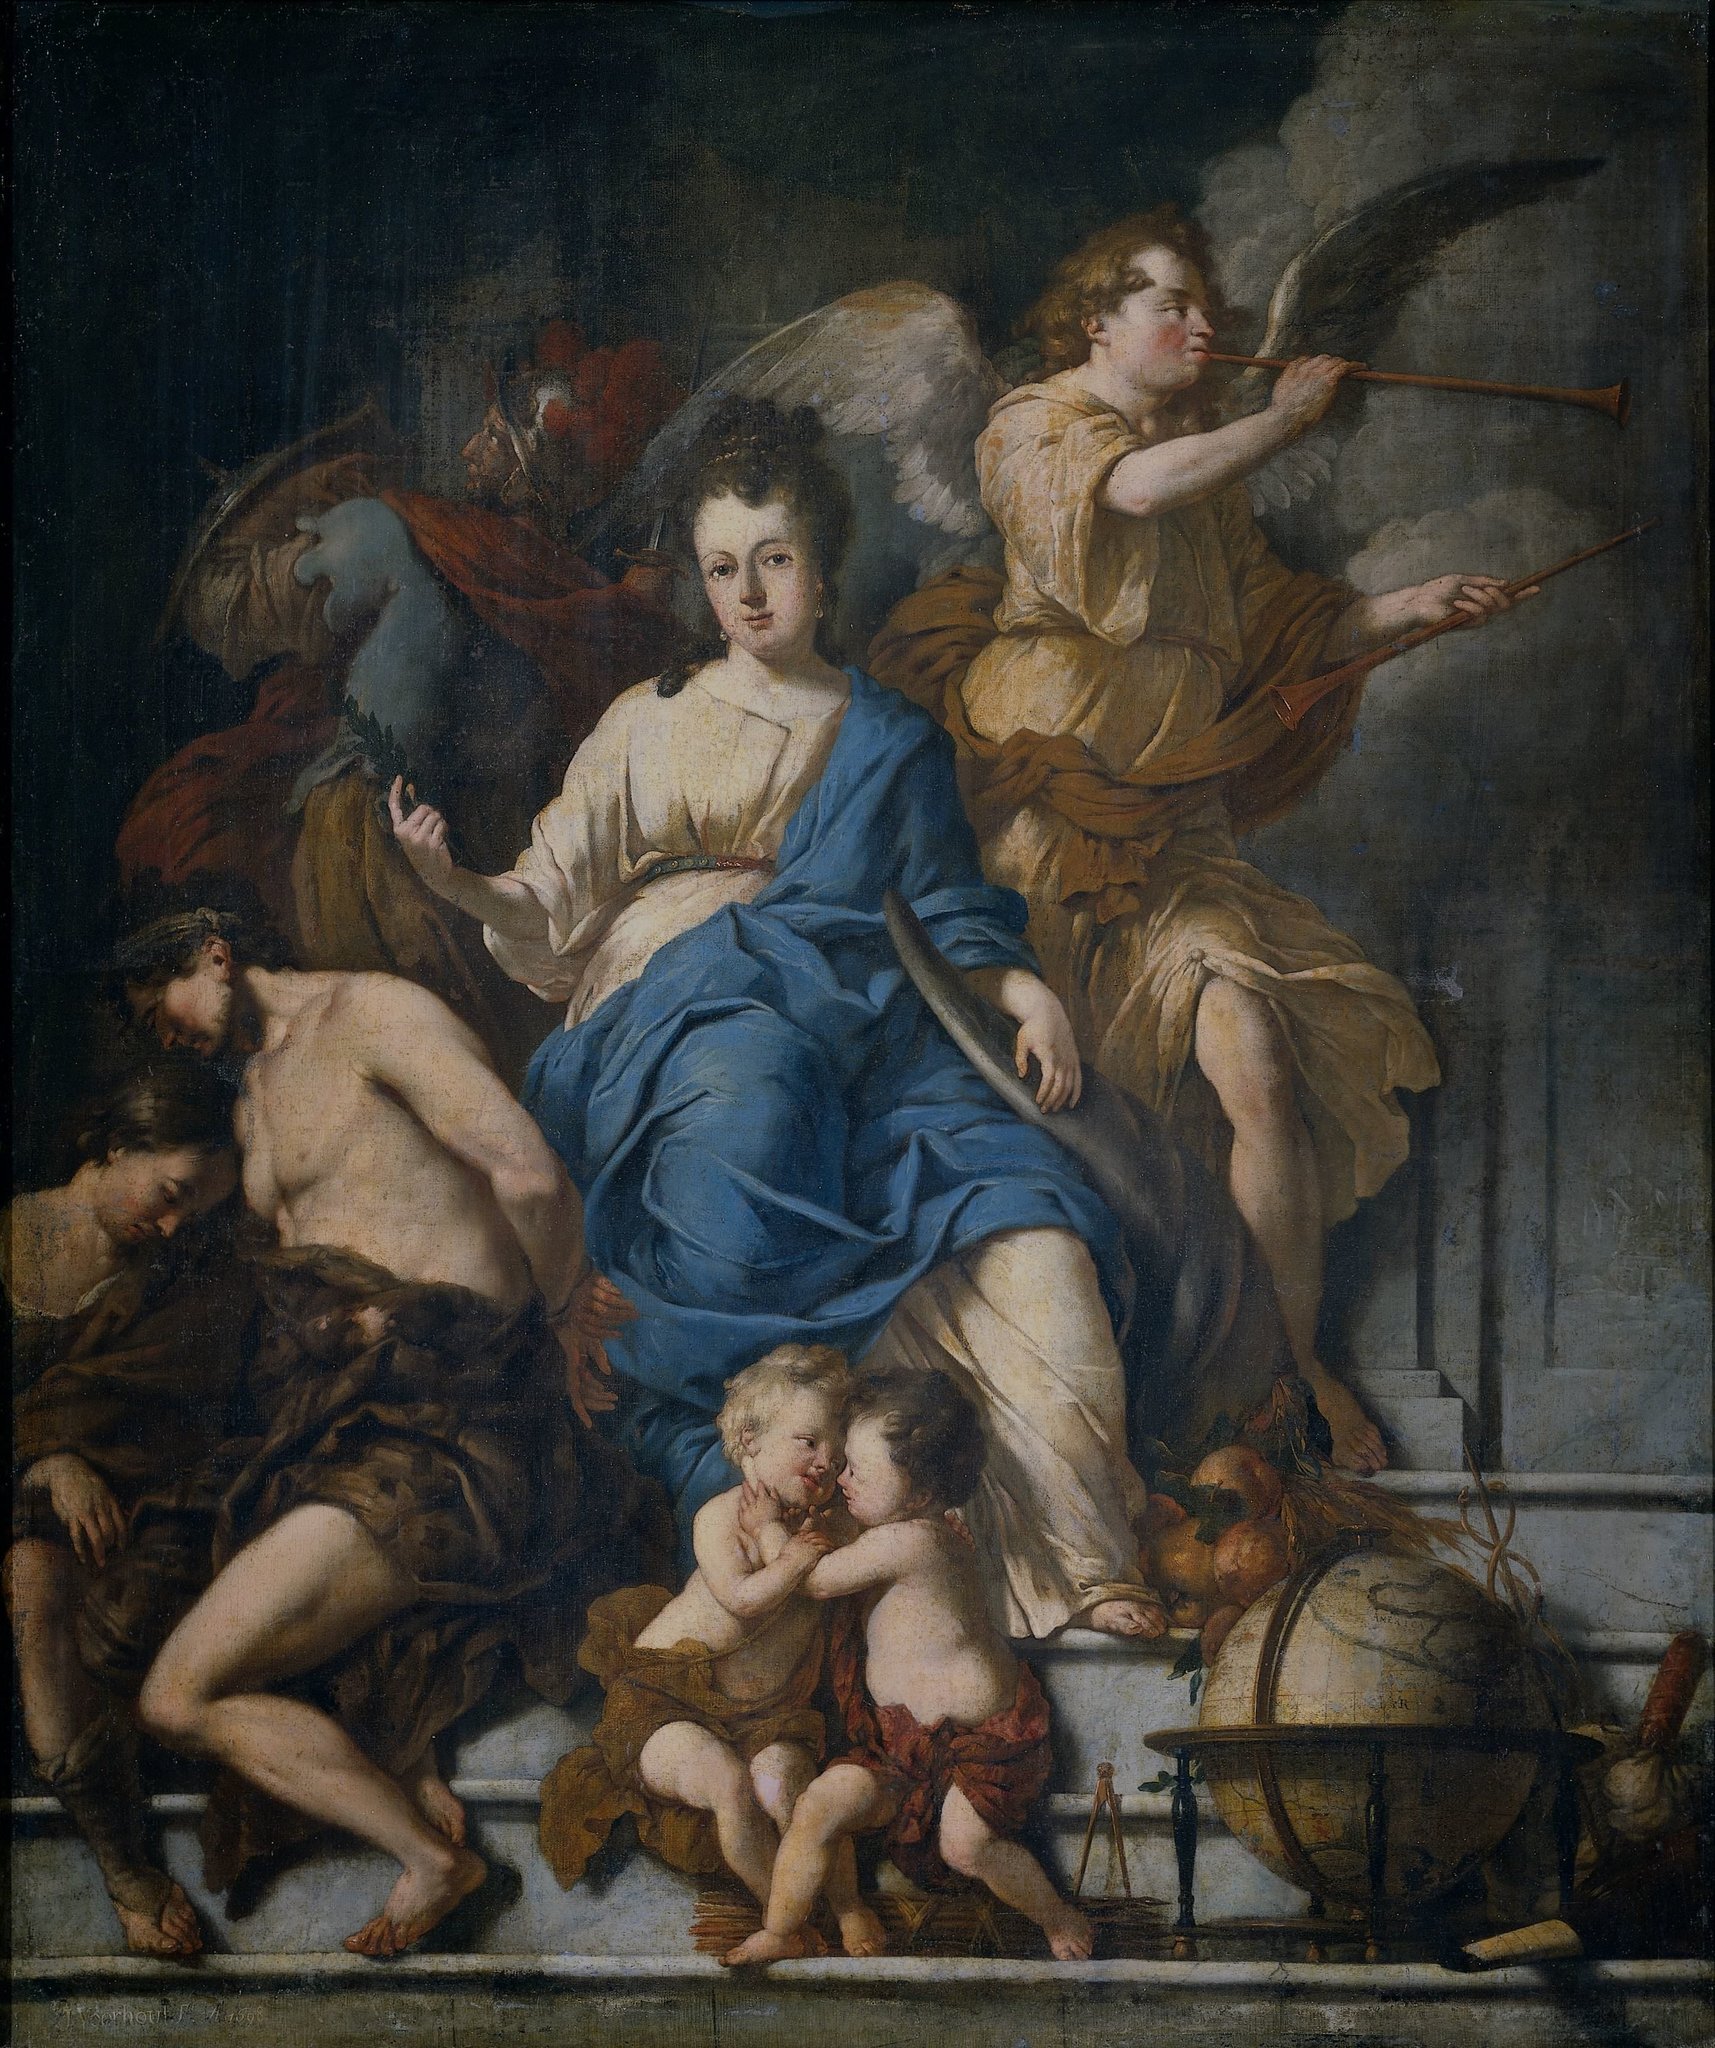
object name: painting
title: Allegory of the Treaty of Ryswick, 1697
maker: johannes voorhout (i)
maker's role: draughtsman, painter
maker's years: 1647-1723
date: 1698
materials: canvas, oil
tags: symbols, allegories of peace, 'pax'; 'pace' (ripa), fame; 'fama', 'fama buona', 'fama chiara' (ripa) (+ personification), prisoner of war (after the battle)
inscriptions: signature and date: ‘J. Voorhout Ft A 1698’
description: De zittende vrouw symboliseert de vrede. Zij toont een olijftak en een hoorn des overvloeds, want 'vrede baart overvloed'. Een krijgsman vlucht weg terwijl de Faam de loftrompet steekt. Terzijde twee geboeide gevangenen.